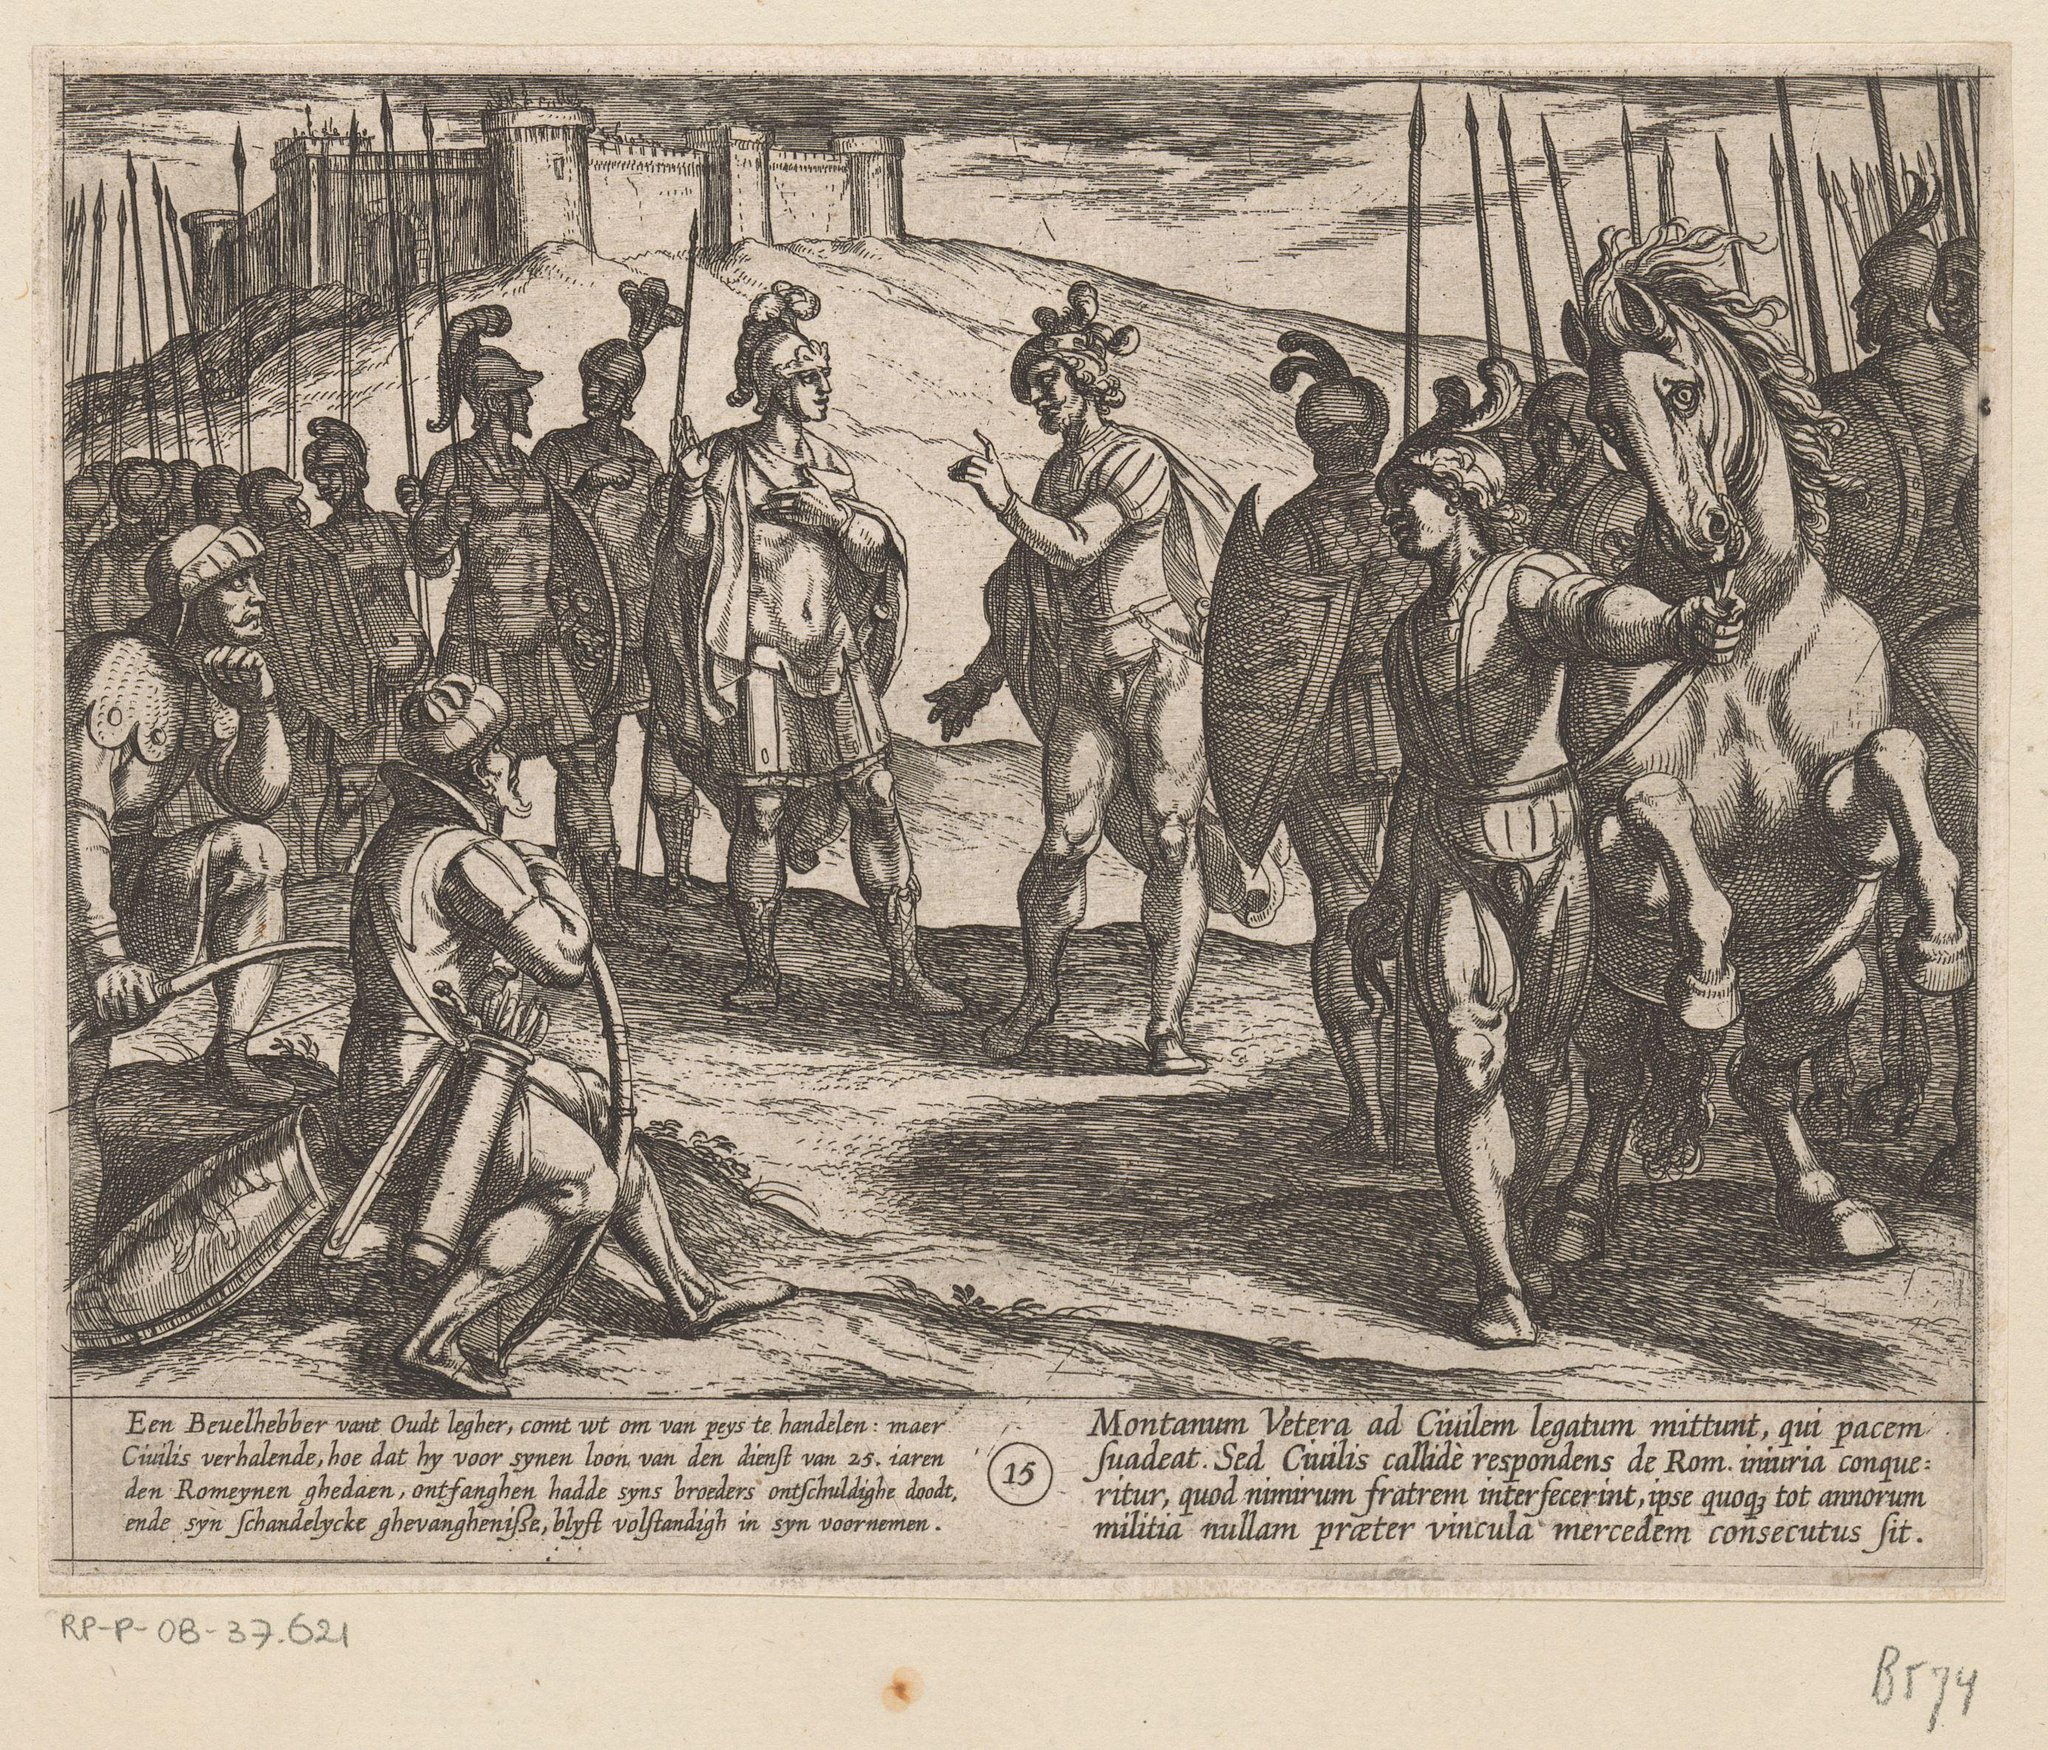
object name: print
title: Julius Civilis onderhandelt met een Romeins bevelhebber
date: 1611-1612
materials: paper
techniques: etching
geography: southern netherlands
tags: commander-in-chief, general, marshal, the soldier; the soldier's life, negotiations between combatants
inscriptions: collector's mark: Lugt 240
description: Deze prent maakt deel uit van een reeks van 36 prenten (+ titelpagina) over de oorlogen tussen de Romeinen en de Bataven.